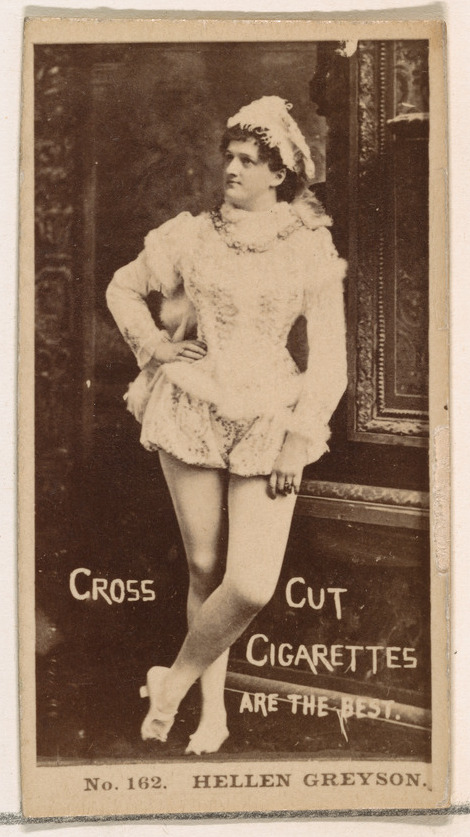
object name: print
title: Card Number 162, Hellen Greyson, from the Actors and Actresses series (N145-2) issued by Duke Sons & Co. to promote Cross Cut Cigarettes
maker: w. duke, sons & co.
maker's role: publisher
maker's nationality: american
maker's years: 1870-1920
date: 1880-1889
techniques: albumen silver print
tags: portraits,women,actresses